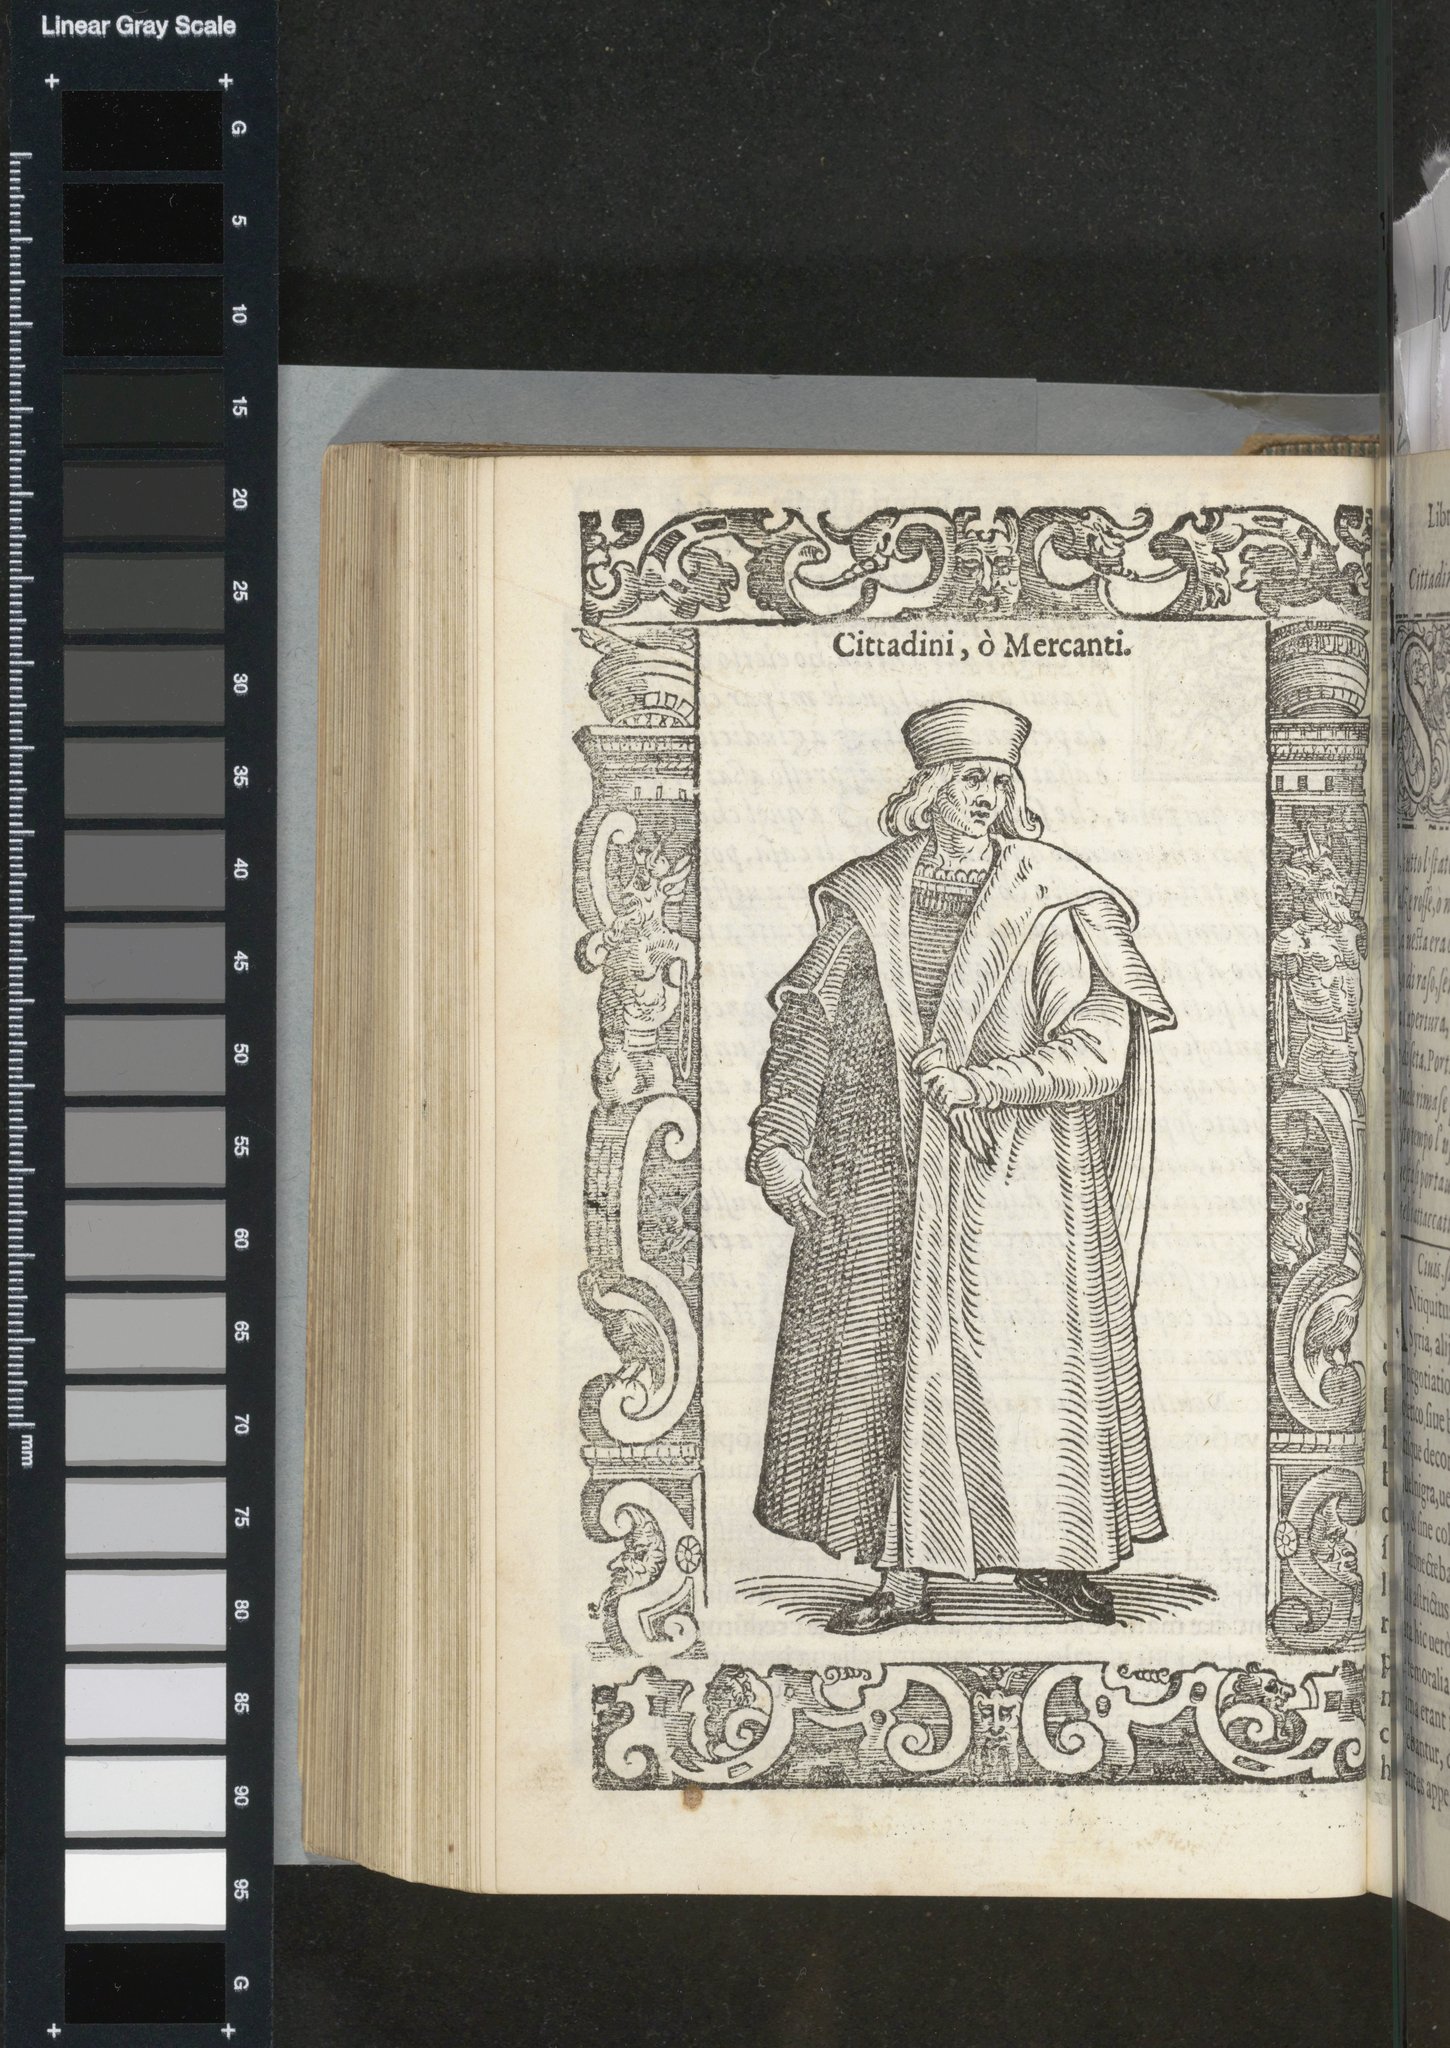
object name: costume print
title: Habiti antichi, et moderni di tutto il mondo..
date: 1598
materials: paper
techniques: woodcut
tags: fashion plates